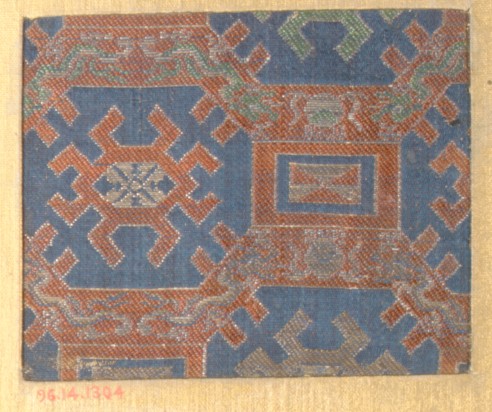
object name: piece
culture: japanese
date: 1701-1900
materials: silk